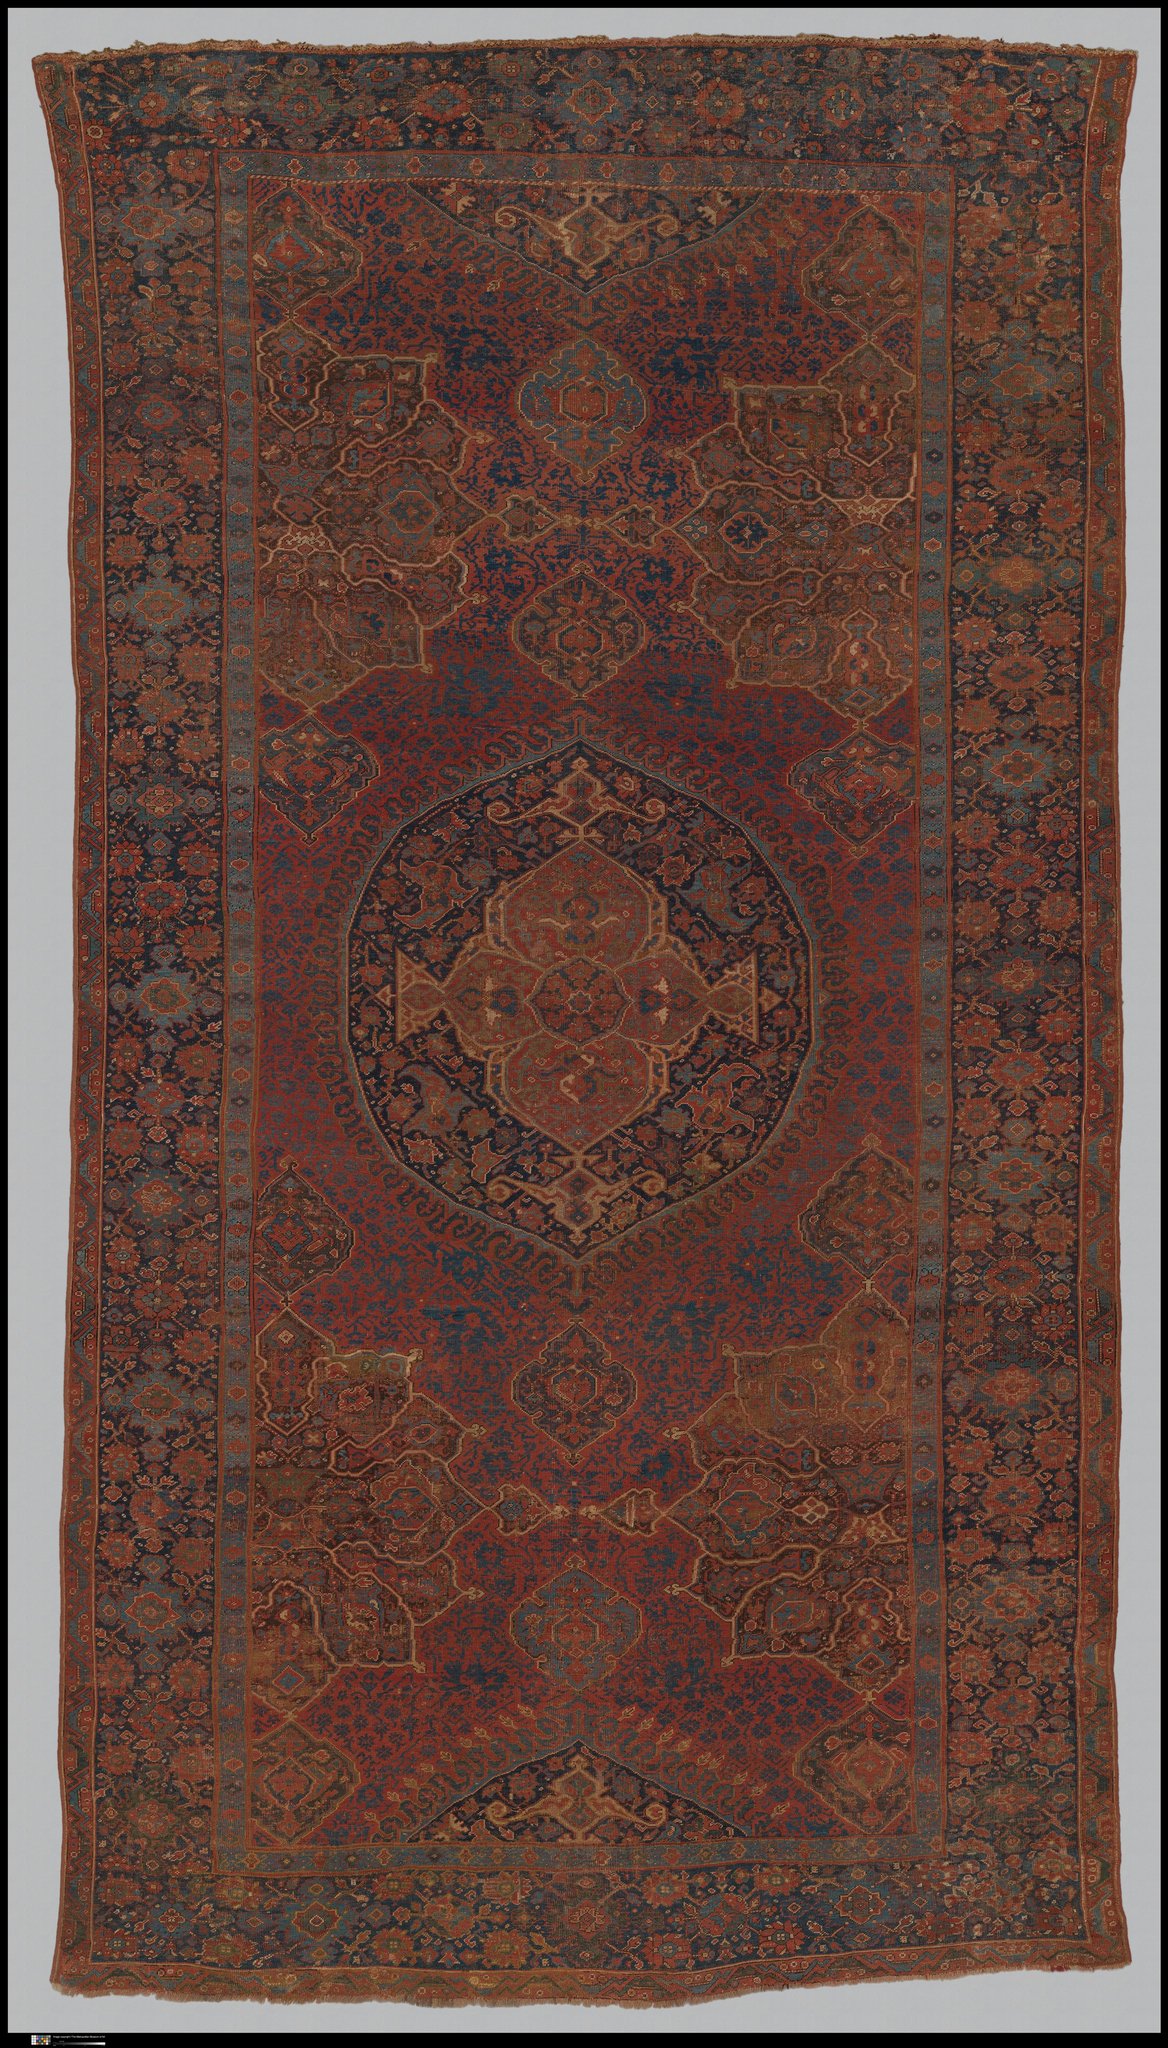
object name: carpet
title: "Medallion Ushak" Carpet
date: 1601-1700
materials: wool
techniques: pile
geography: turkey